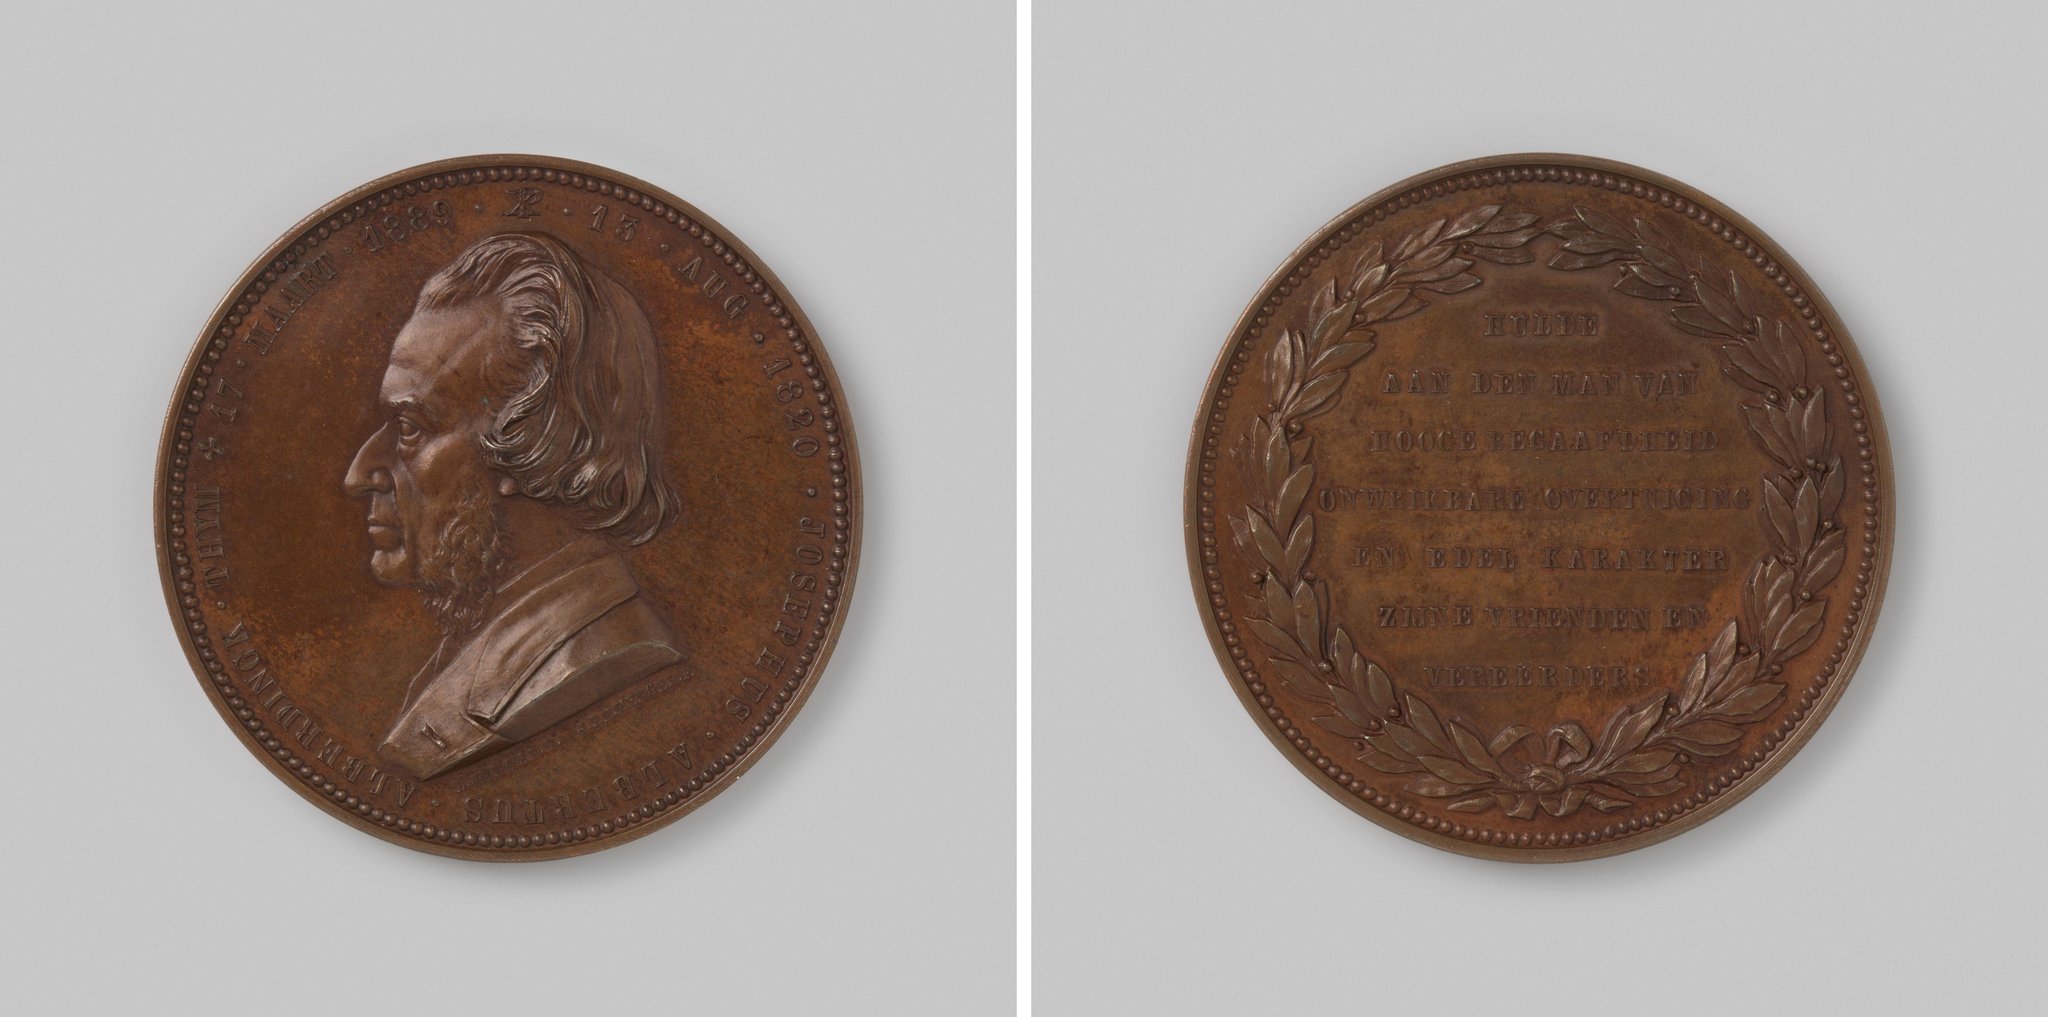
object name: history medal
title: Overlijden van J.A. Alberdingk Thijm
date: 1889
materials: bronze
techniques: striking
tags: amsterdam, painter, draughtsman, publisher, josephus albertus alberdingk thijm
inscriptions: inscription: ‘HULDE / AAN DEN MAN VAN / HOOGE BEGAAFDHEID / ONWRIKBARE OVERTUIGING / EN EDEL KARAKTER / ZIJNE VRIENDEN EN / VEREERDERS’, signature: ‘L. Jünger J.P.M.Menger’, inscription: ‘XP . 13 . AUG . 1820 . JOSEPHUS . ALBERTUS . ALBERTINGK . THYM + 17 . MAART . 1889 .’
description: Bronzen penning. Voorzijde: kop J.A. Alberdingk Thijm, en profil naar links, met omschrift . Keerzijde: zeven regels tekst in lauwerkrans.